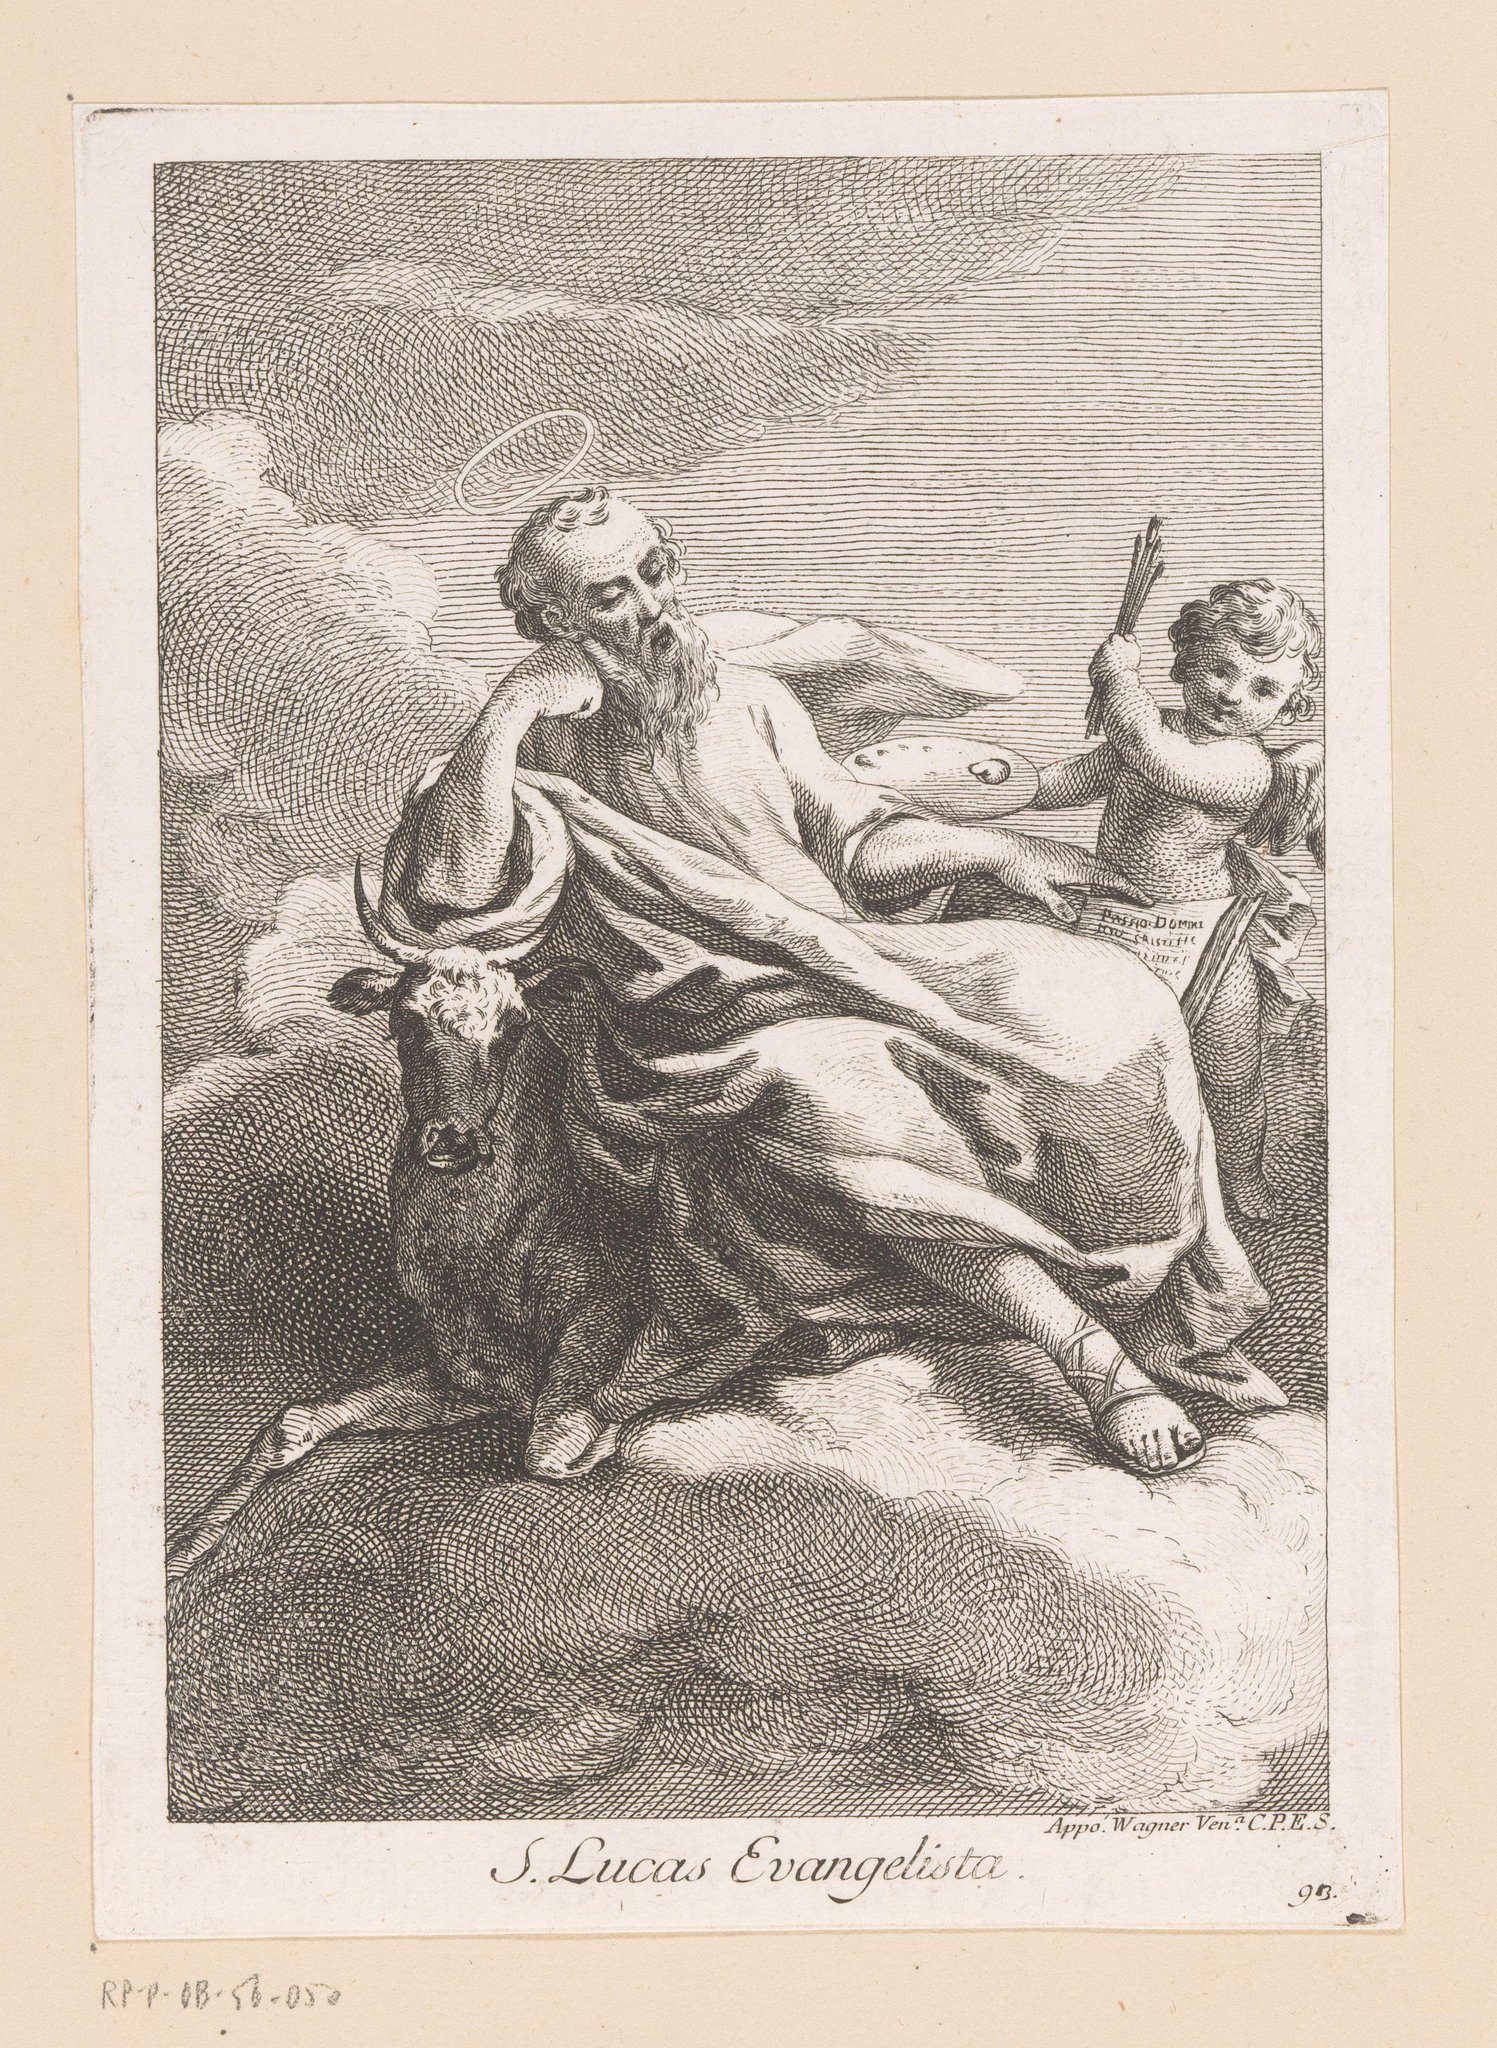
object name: print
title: Lucas de evangelist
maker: joseph wagner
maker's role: painter, print maker, publisher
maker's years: 1706-1780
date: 1739-1780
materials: paper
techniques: etching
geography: venice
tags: luke the evangelist; possible attributes: book, (winged) ox, portrait of the virgin, surgical instruments, painter's utensils, scroll